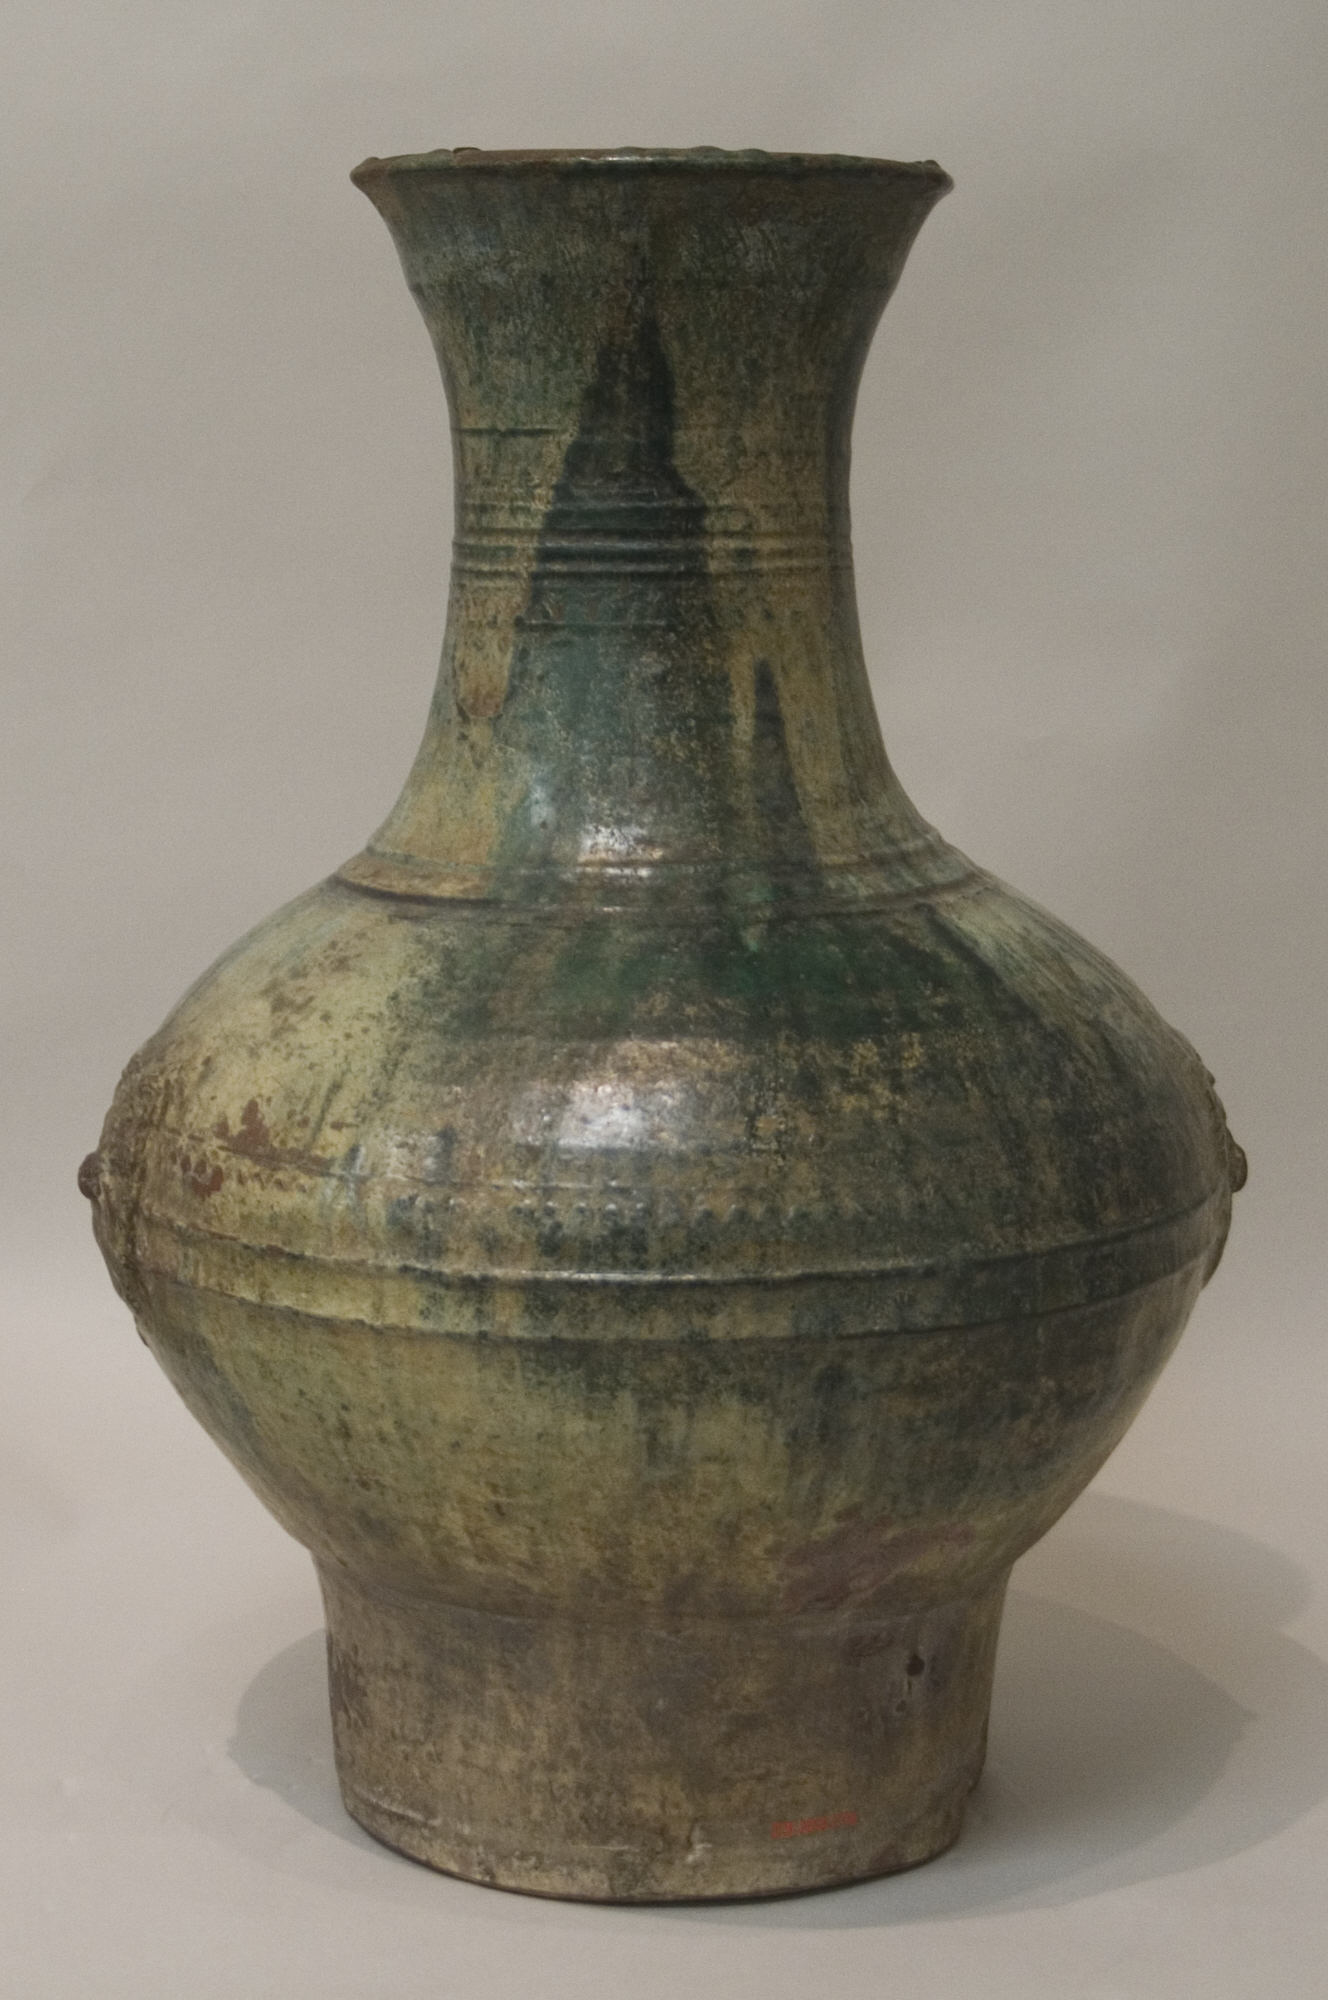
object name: wine container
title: Wine container (hu)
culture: chinese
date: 1-200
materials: earthenware, glaze, lead